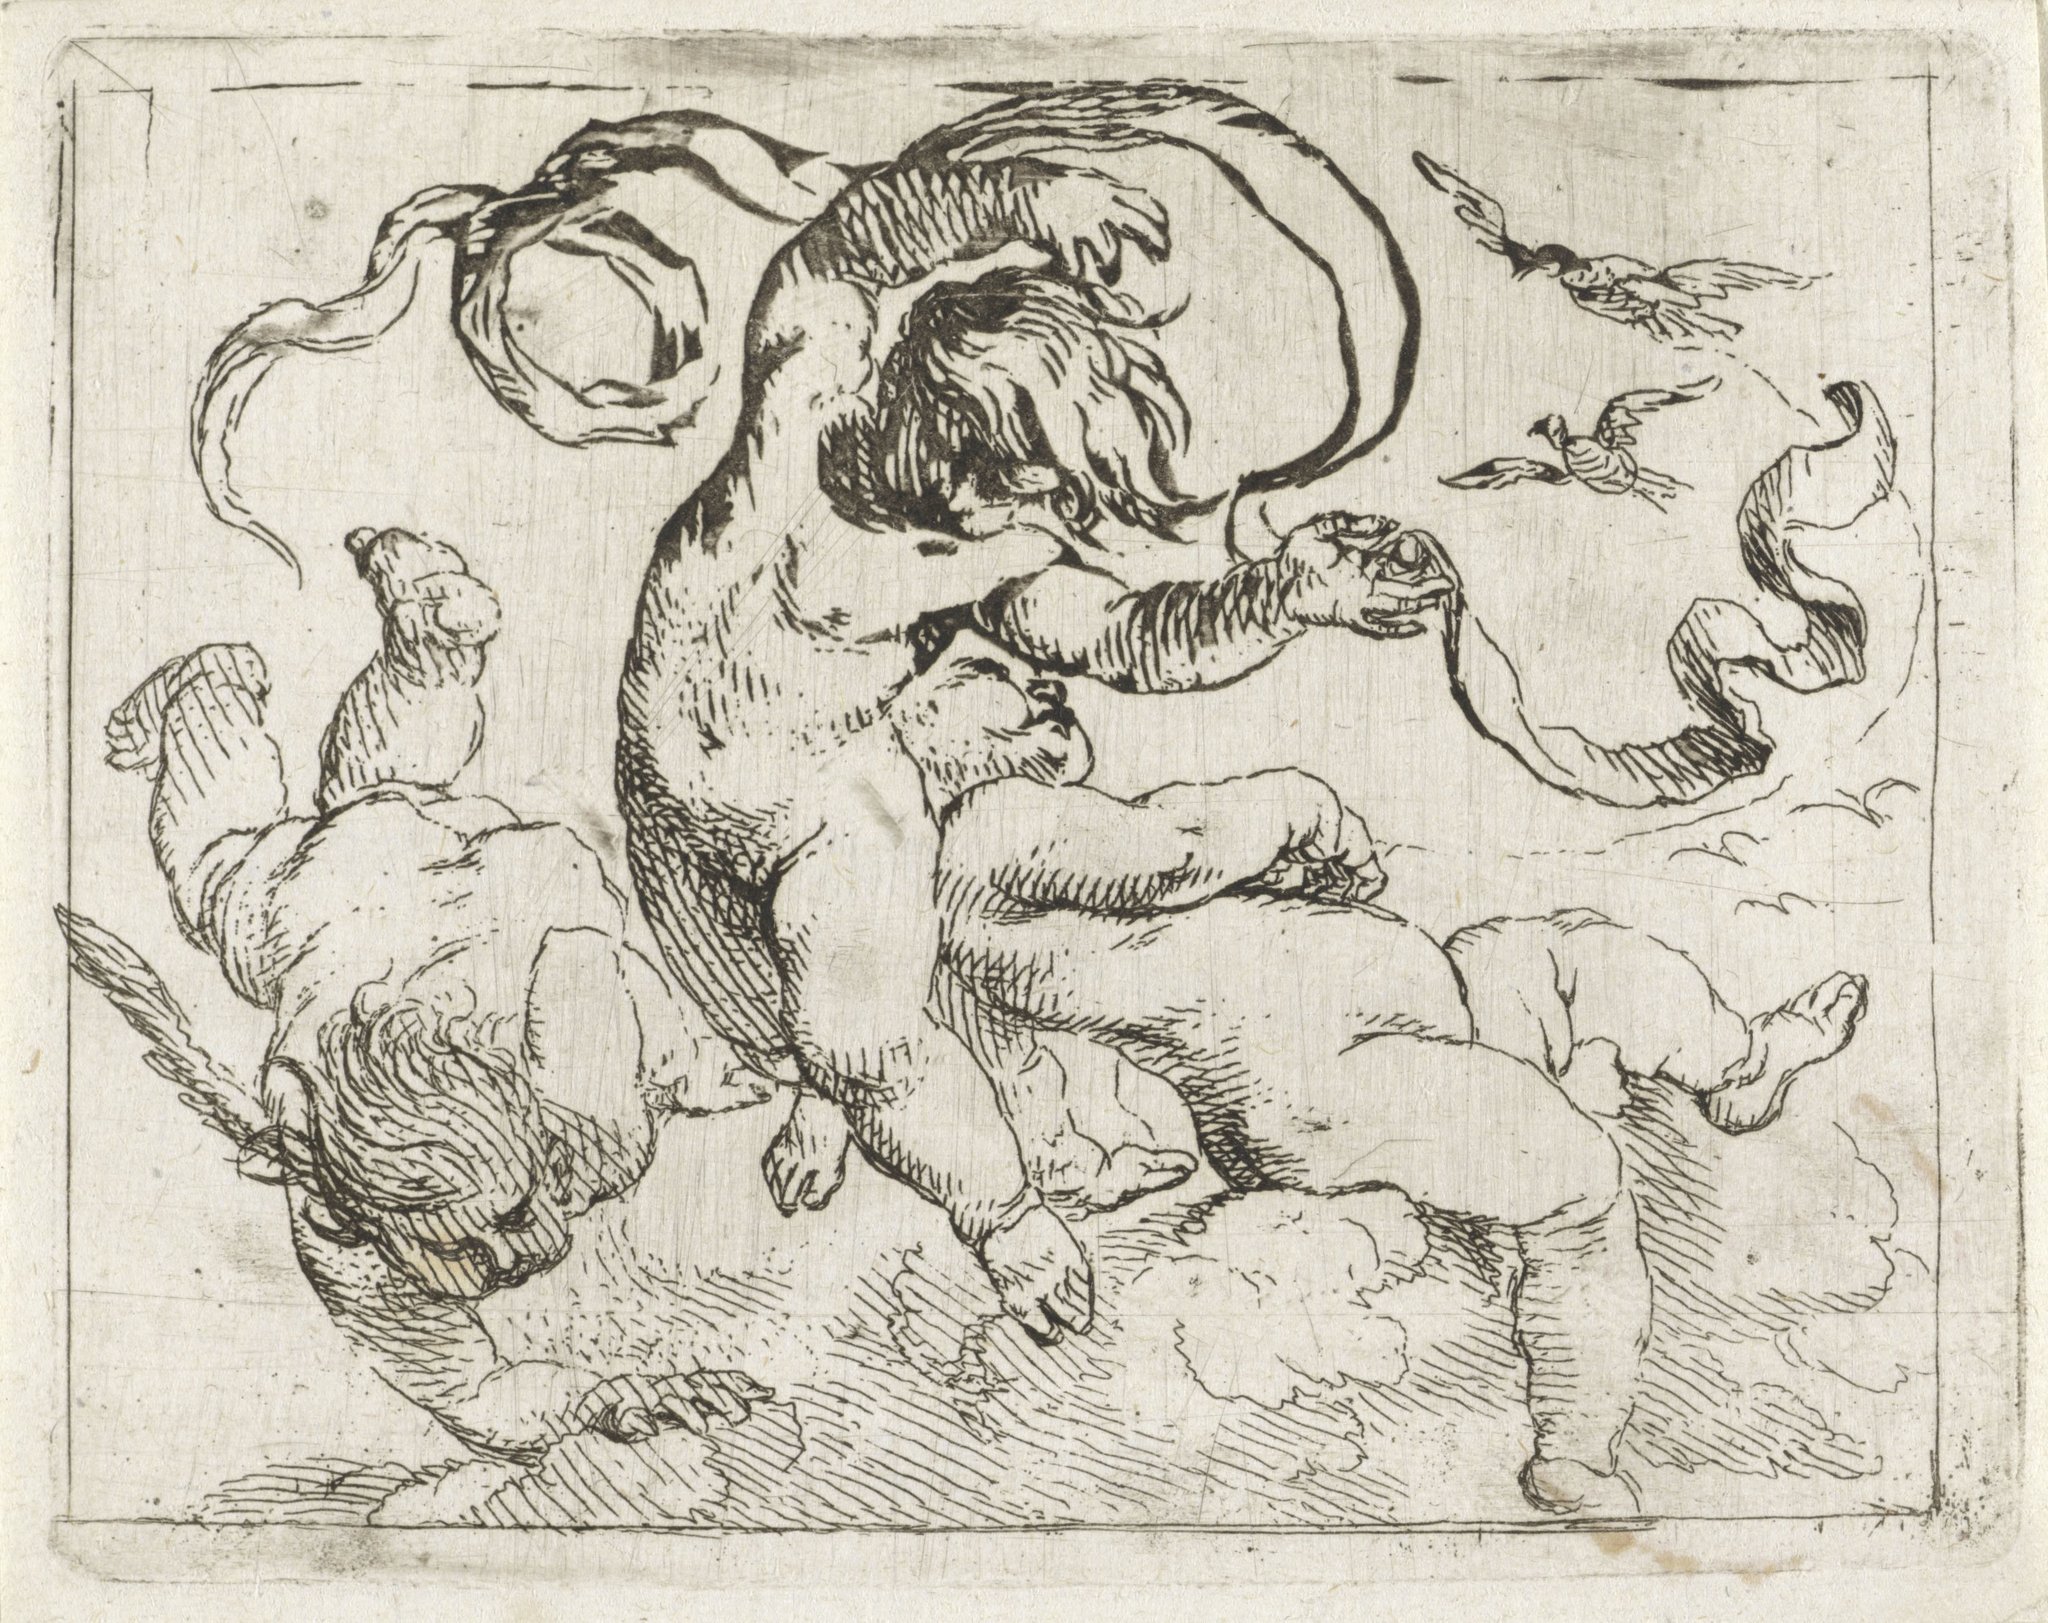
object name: print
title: Drie vliegende putti met banderollen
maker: cornelis schut (i)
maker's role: draughtsman, print maker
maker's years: 1597-1655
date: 1618-1655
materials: paper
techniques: etching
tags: cupids: 'amores', 'amoretti', 'putti'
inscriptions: collector's mark: Lugt 240